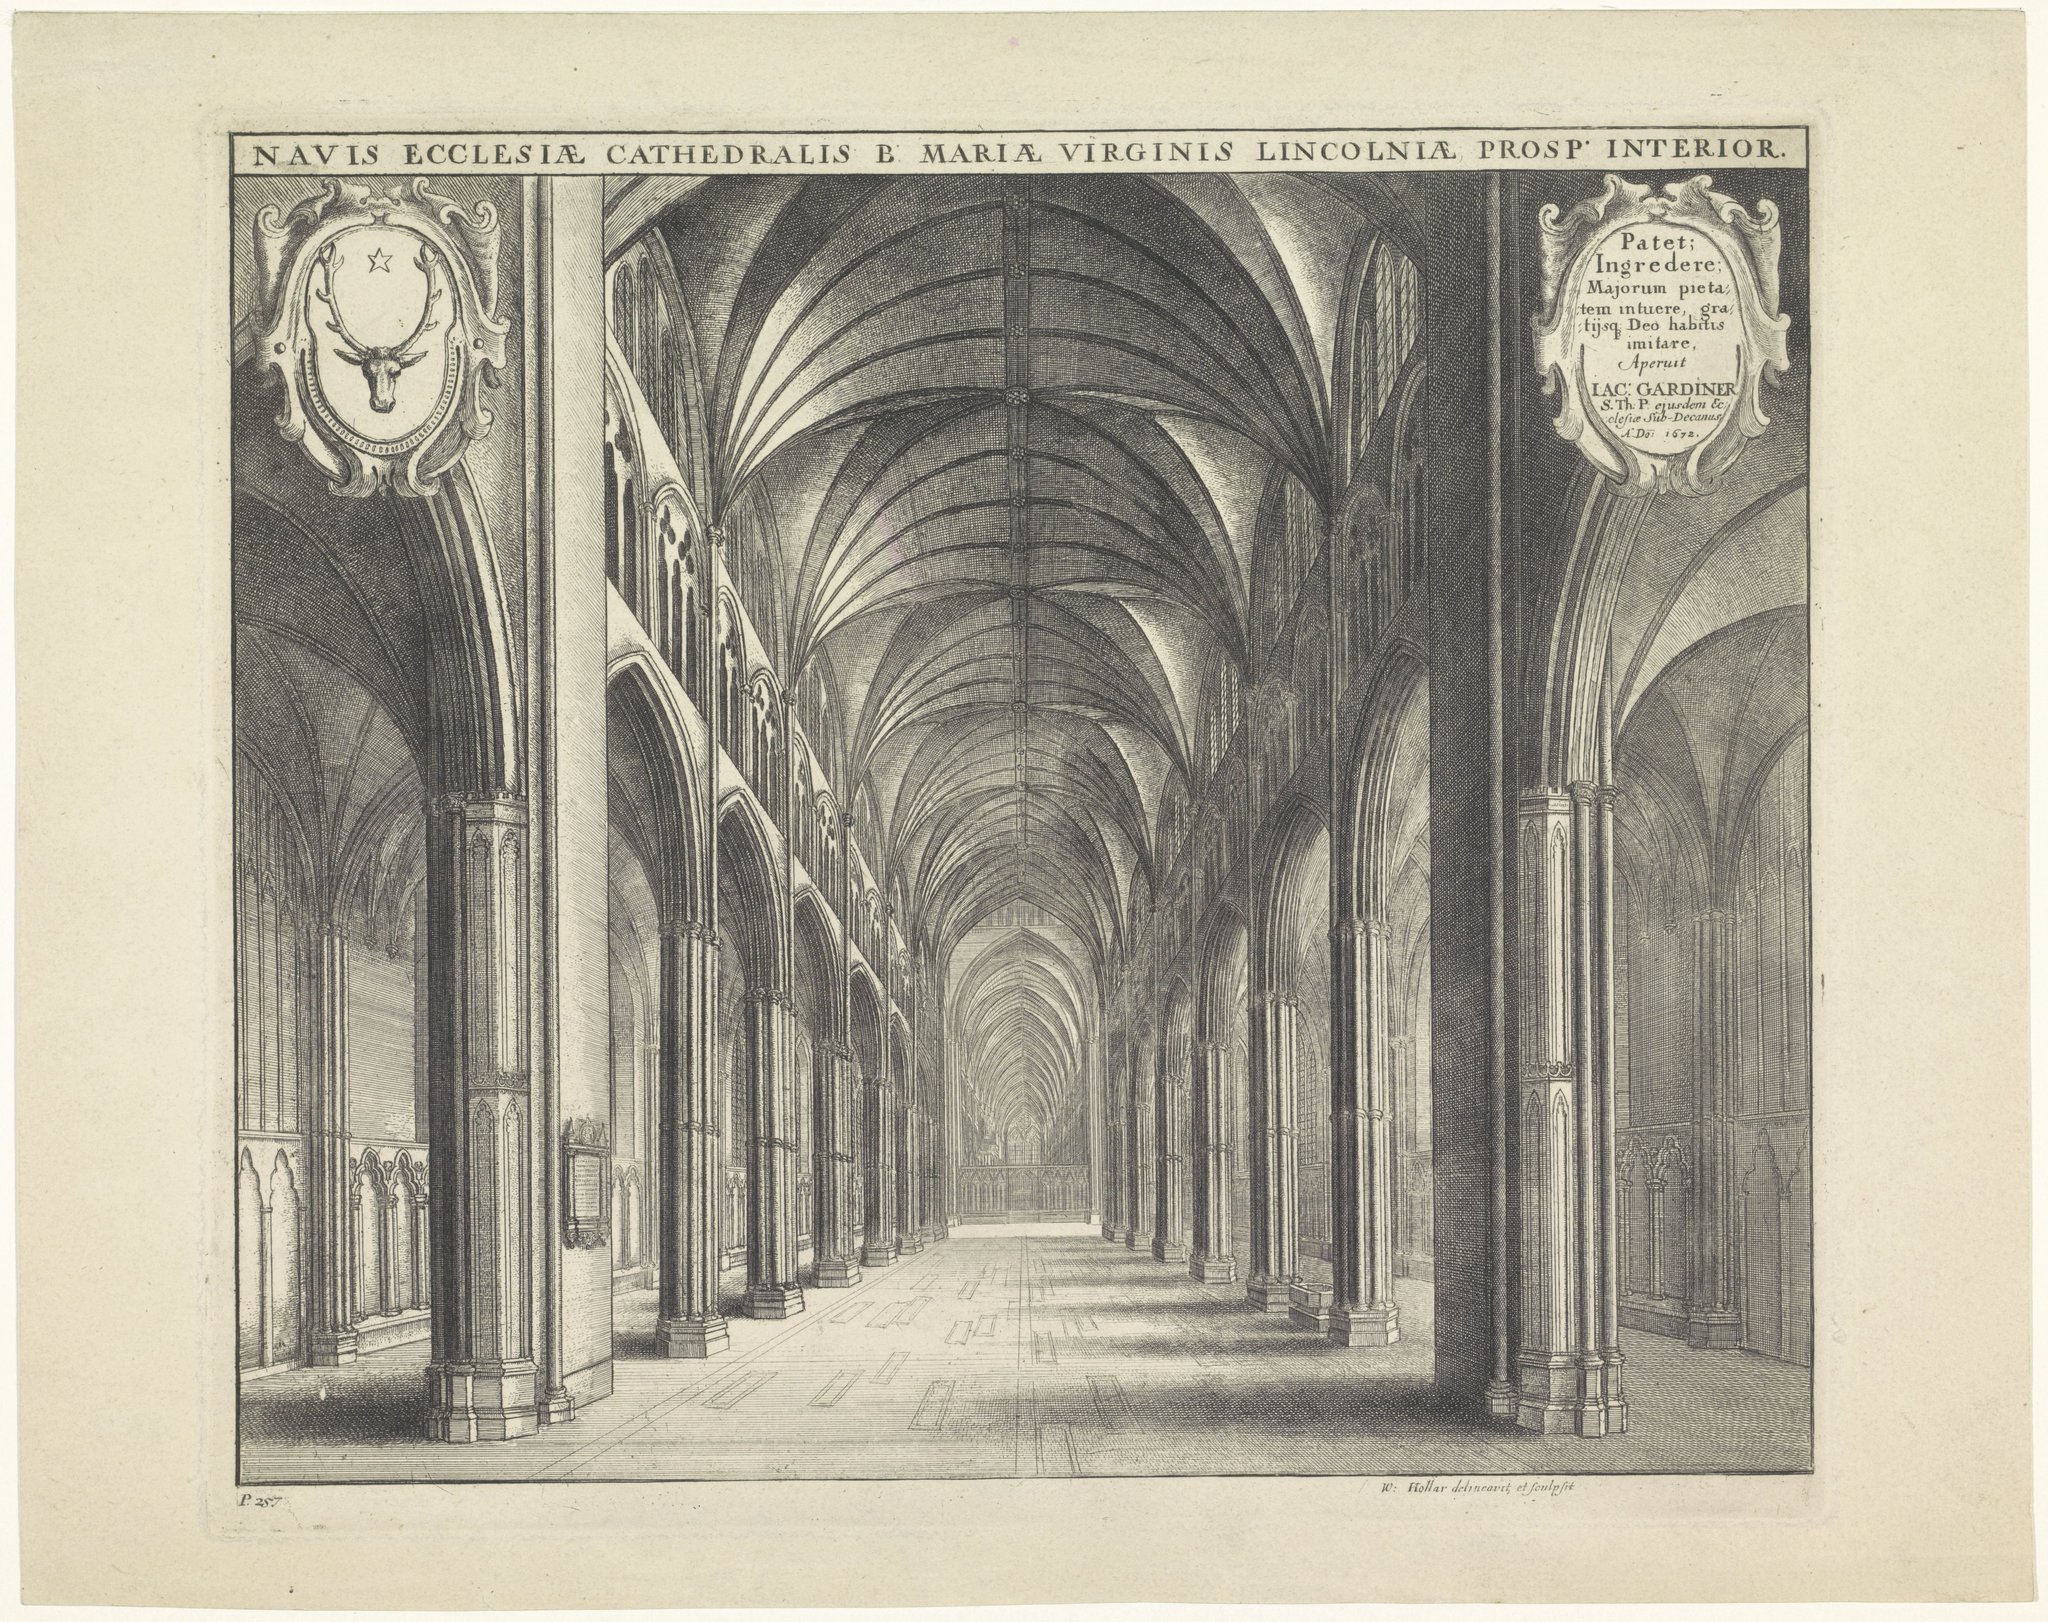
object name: print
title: Interieur van de kathedraal te Lincoln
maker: wenceslaus hollar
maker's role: draughtsman, print maker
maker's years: 1607-1677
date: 1672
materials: paper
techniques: etching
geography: london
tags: interior of church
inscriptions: collector's mark: Lugt 2760, collector's mark: Lugt 2228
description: Illustratie uit: Dugdale, William. Monasticon Anglicanum. Londen, 1673.